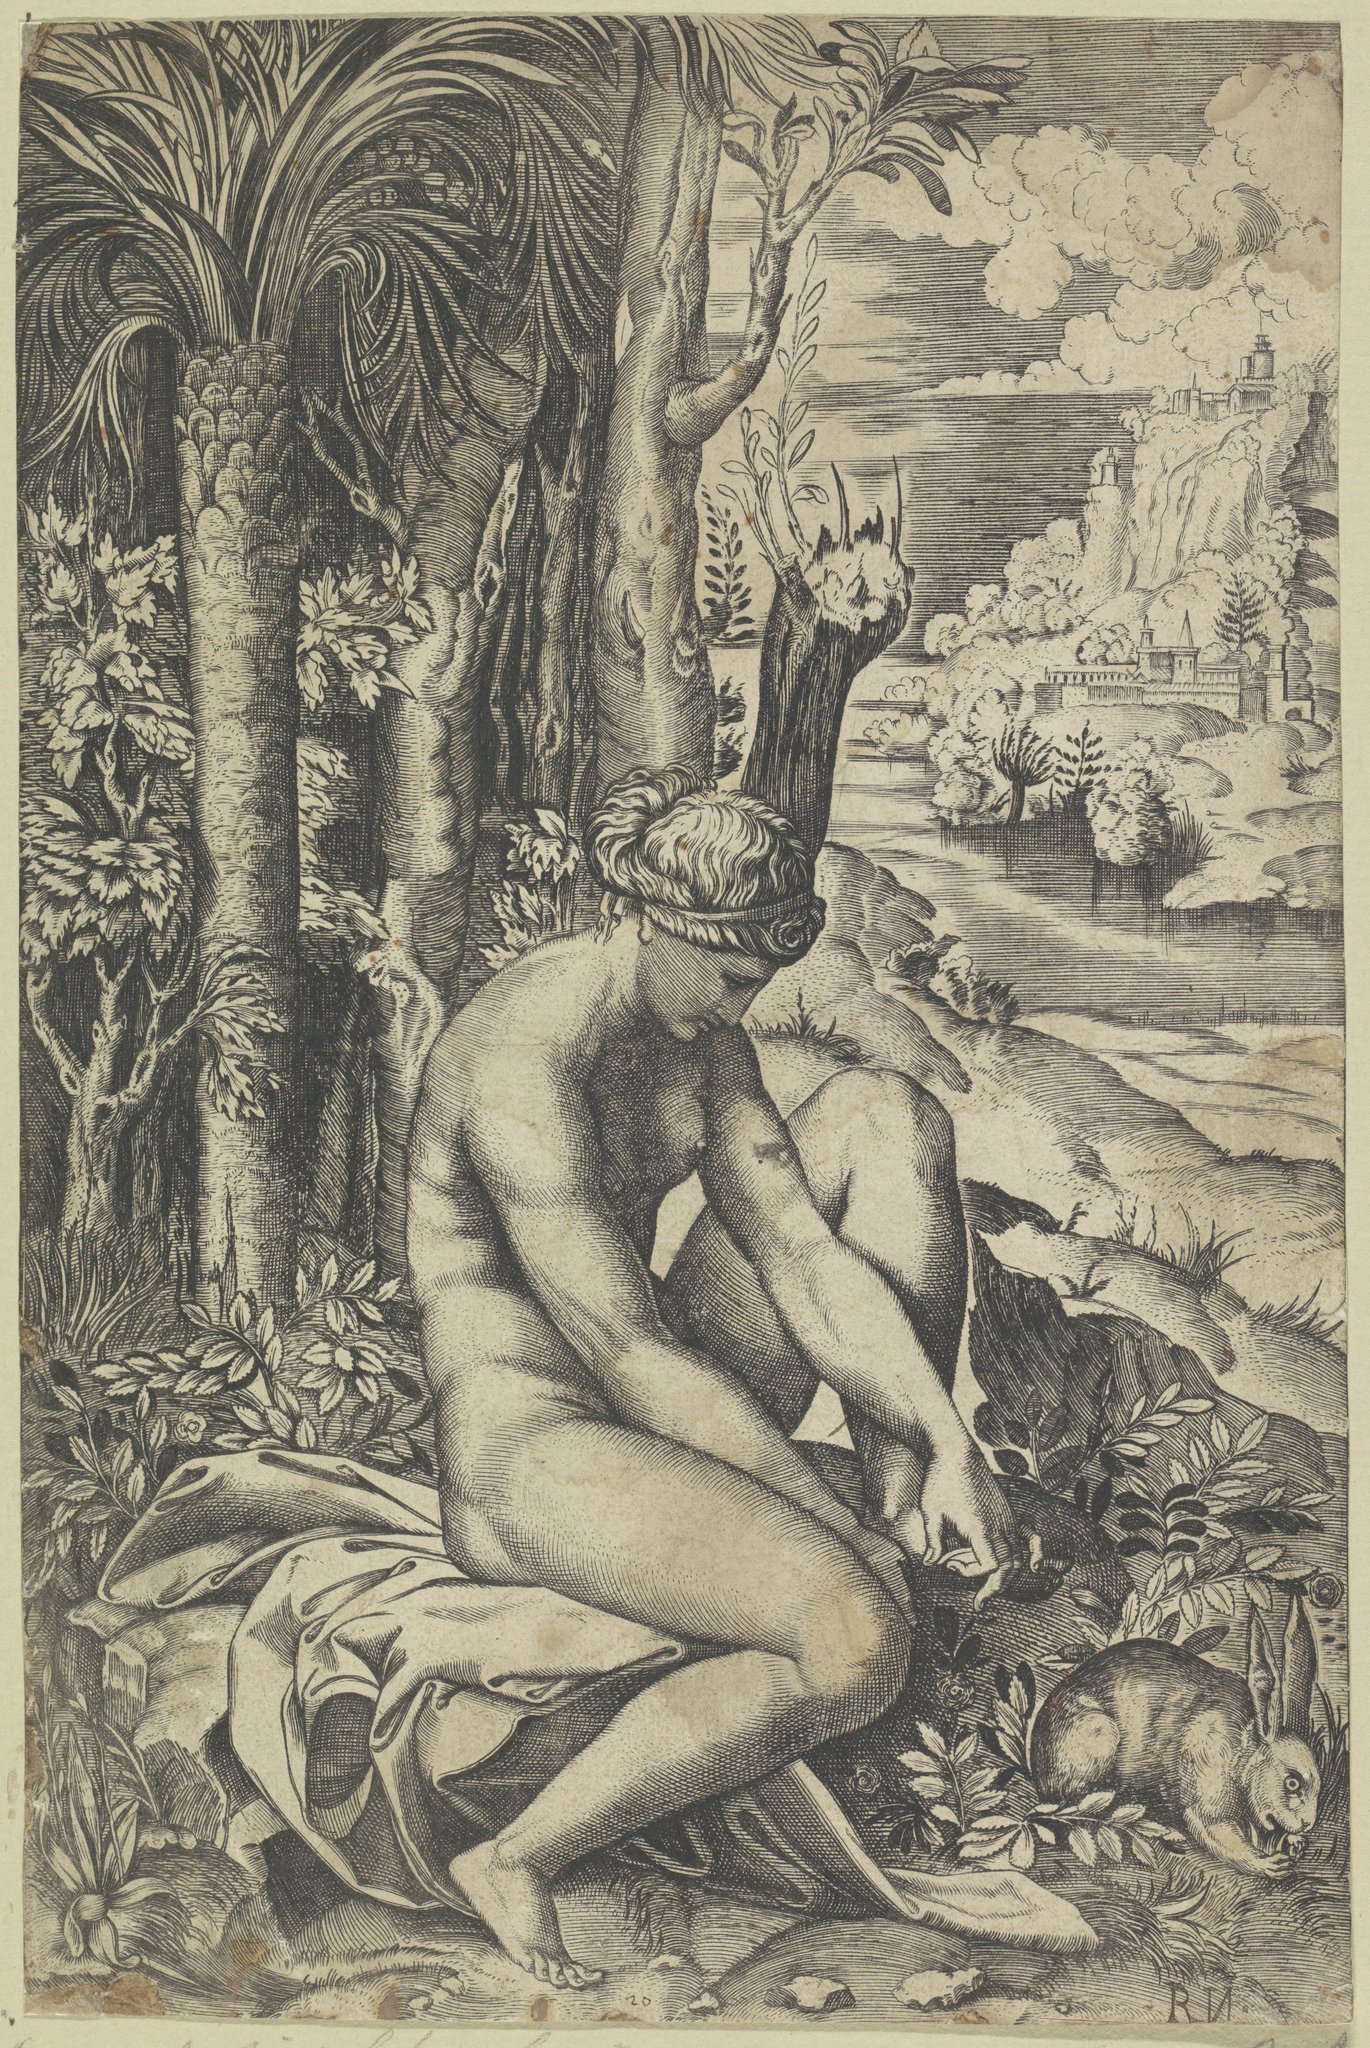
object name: print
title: Venus en de roos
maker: Anonymous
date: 1498-1532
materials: paper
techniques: engraving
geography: italy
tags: venus wounded by the thorns of a rose-bush; the roses change from white to red (possibly combined with the story of adonis)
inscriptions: inscription: ‘RN’, collector's mark: Lugt 240, number: ‘20’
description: Venus zit op een rots in een landschap. Ze haalt een doorn van een rozenstruik uit haar voet. Op de voorgrond rechts een konijn.